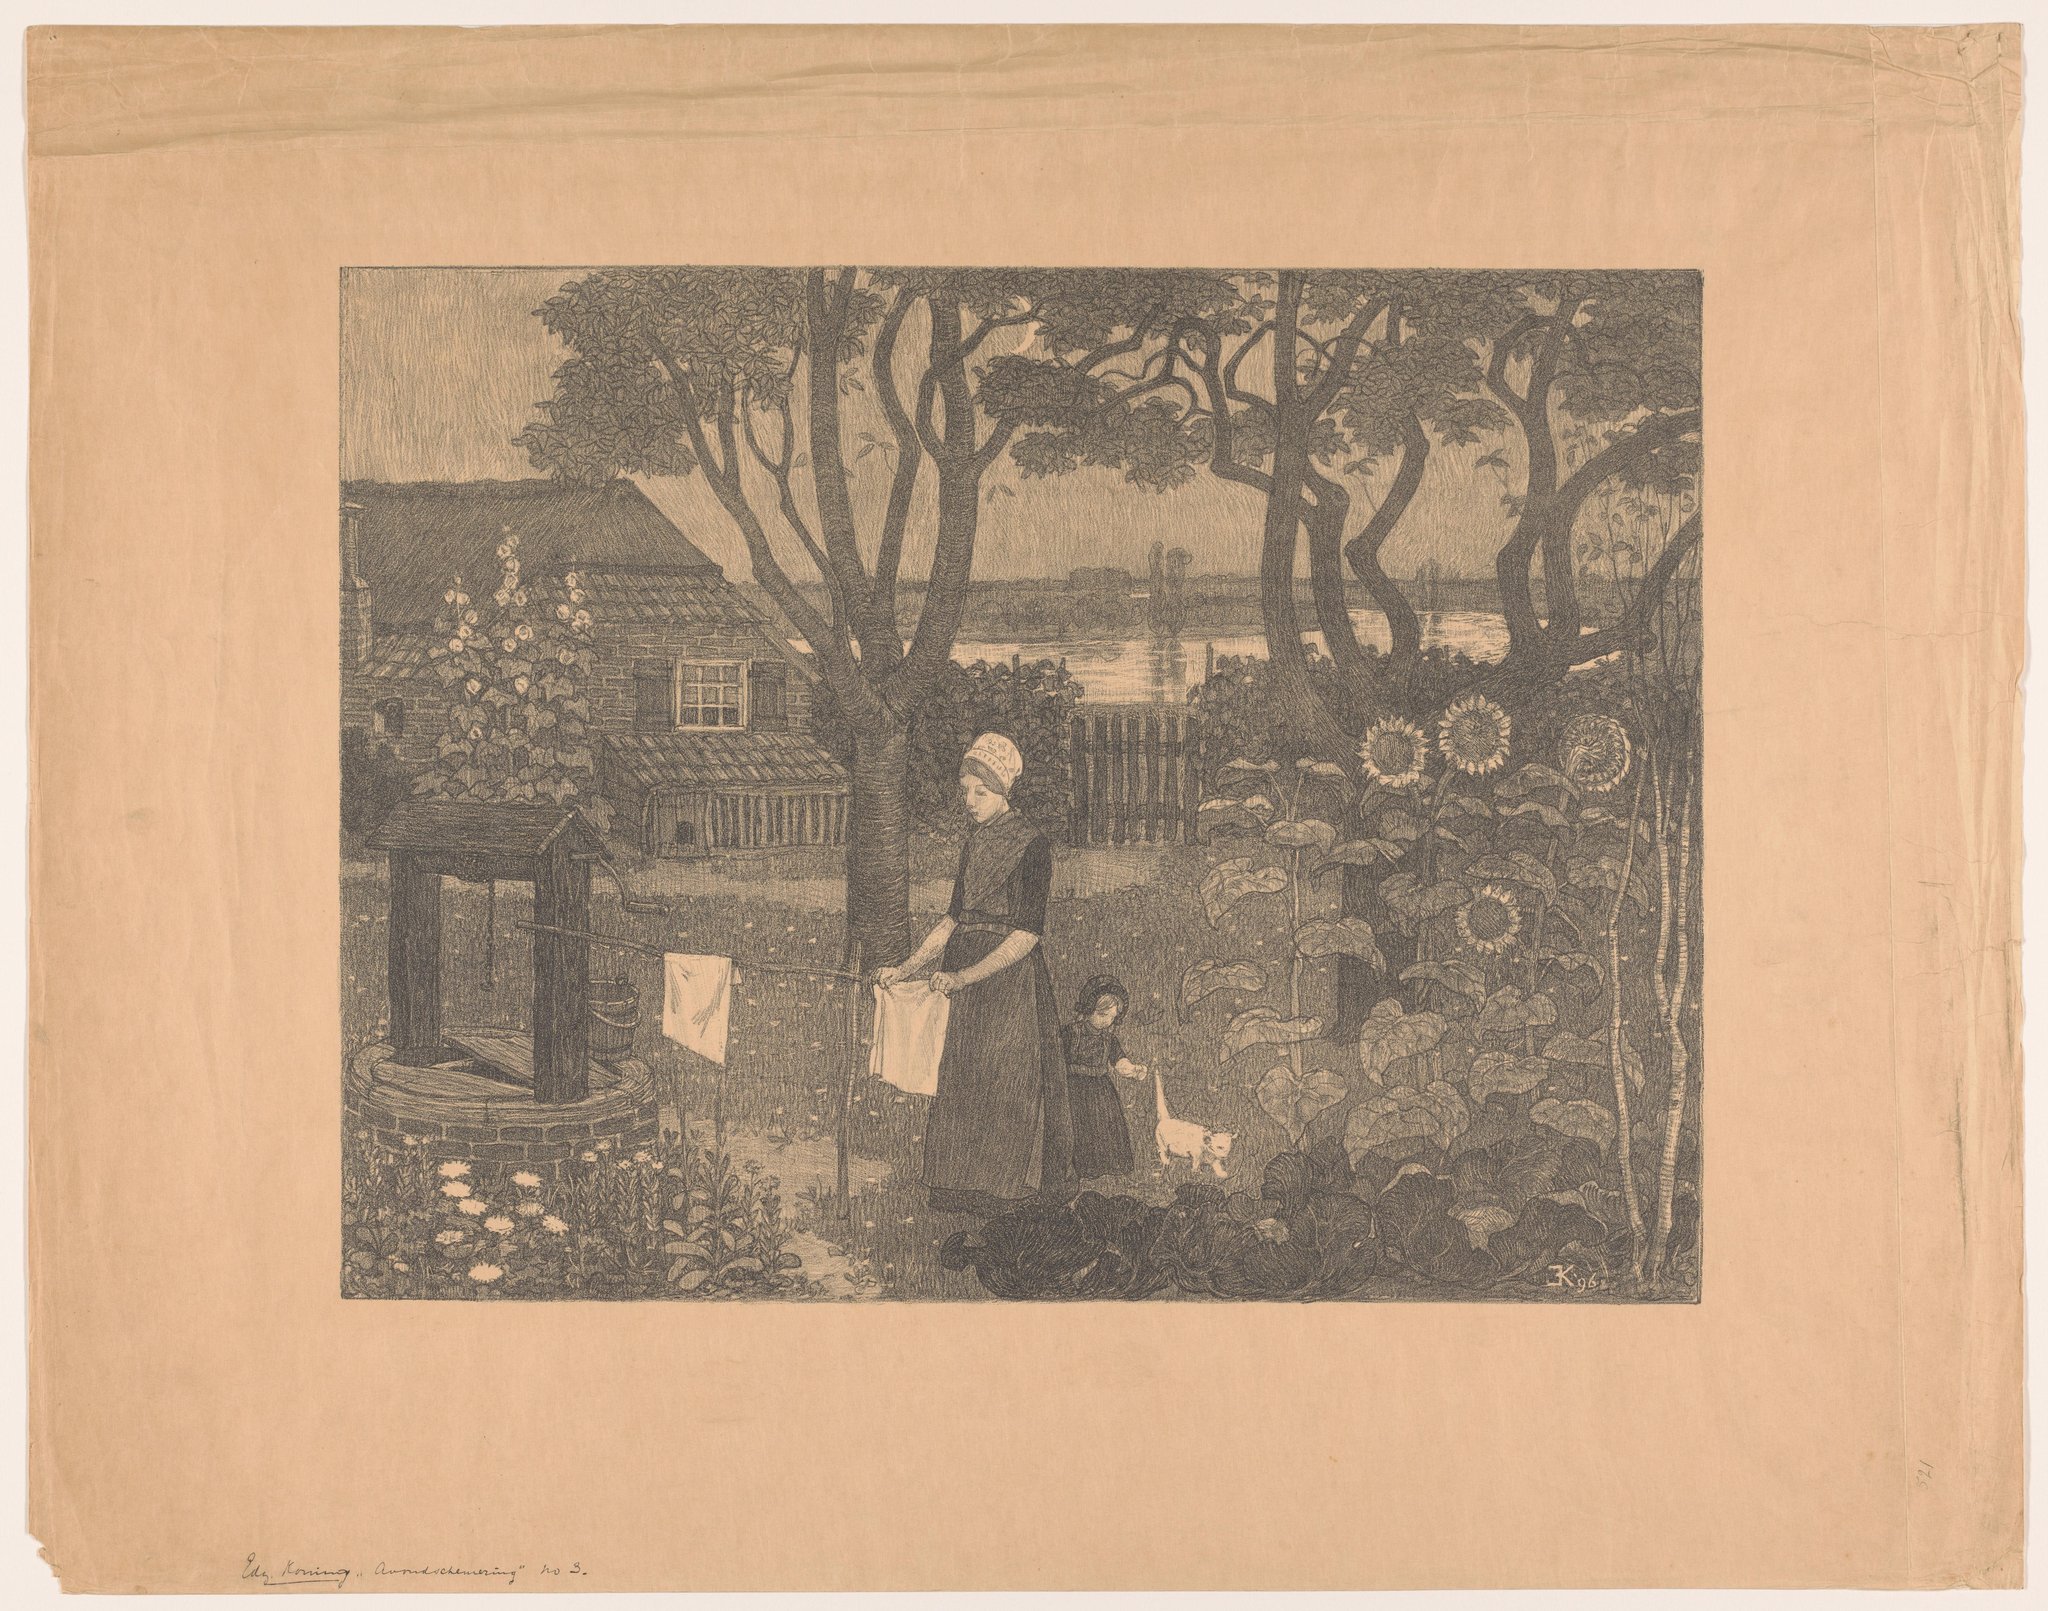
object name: print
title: Avondschemering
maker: edzard koning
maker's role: draughtsman, print maker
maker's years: 1869-1954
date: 1896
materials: paper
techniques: lithograph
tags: well, mother and daughter(s) (family group), farm or solitary house in landscape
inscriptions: date